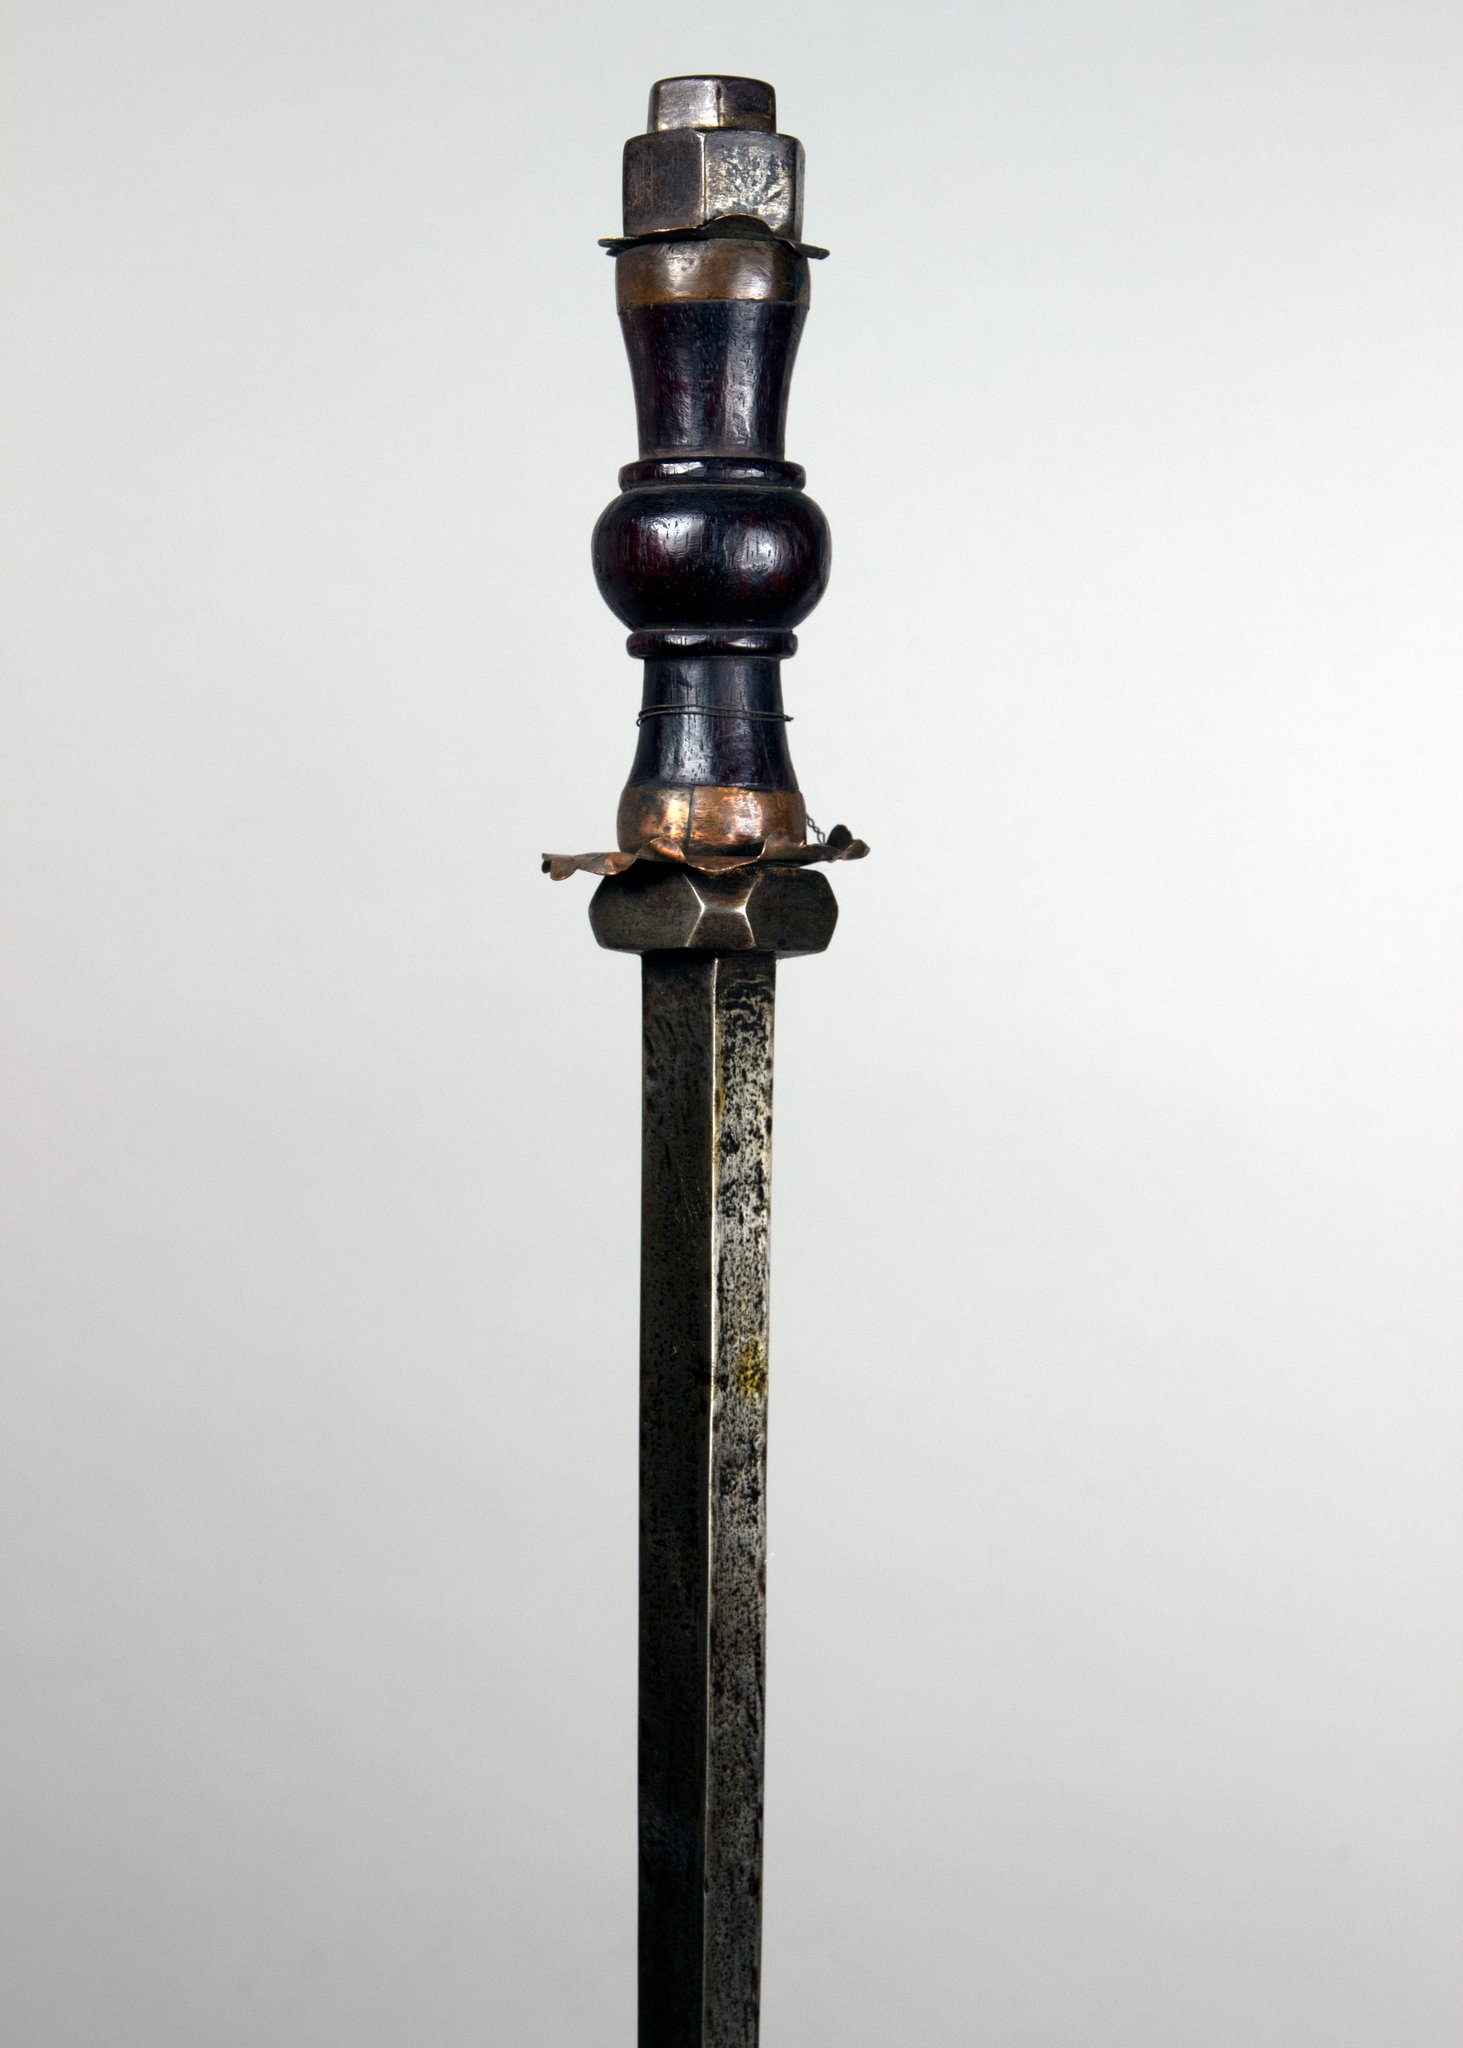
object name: mace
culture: chinese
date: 1701-1900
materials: copper, steel, wood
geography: china